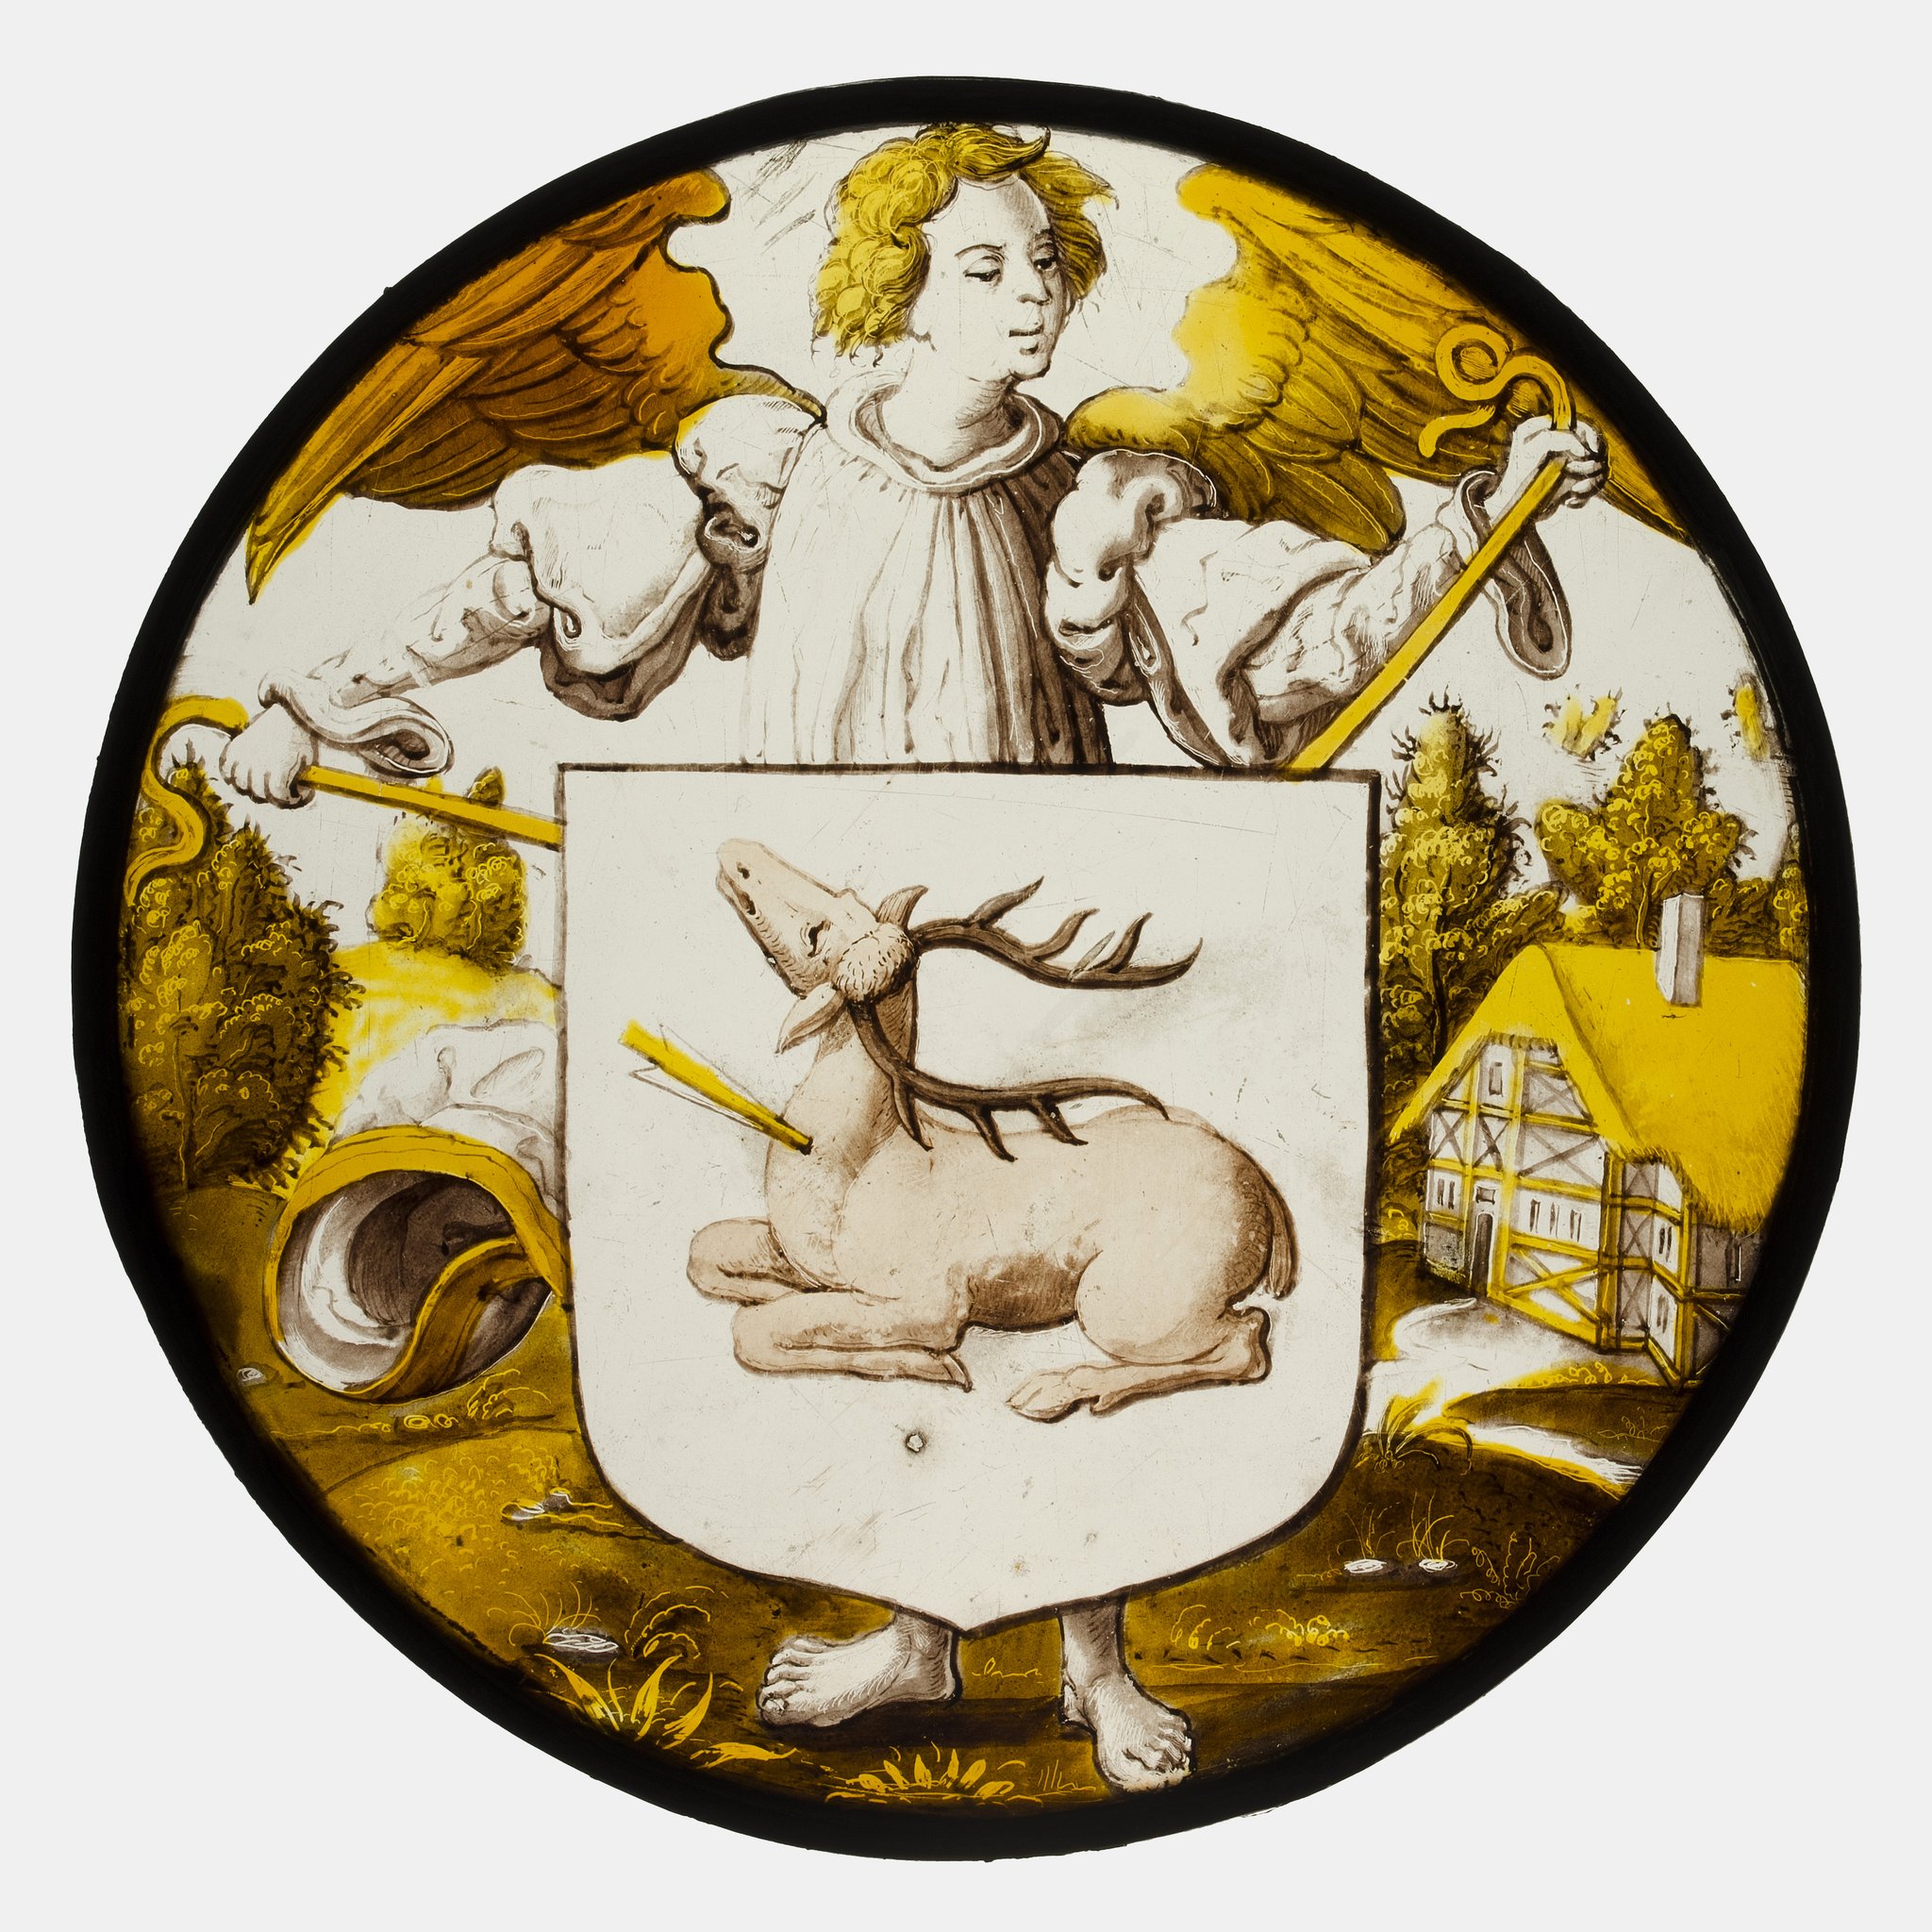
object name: roundel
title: Roundel with Angel Supporting a Heraldic Shield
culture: south netherlandish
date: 1530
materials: glass, paint, pigment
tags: deer,angels,coat of arms